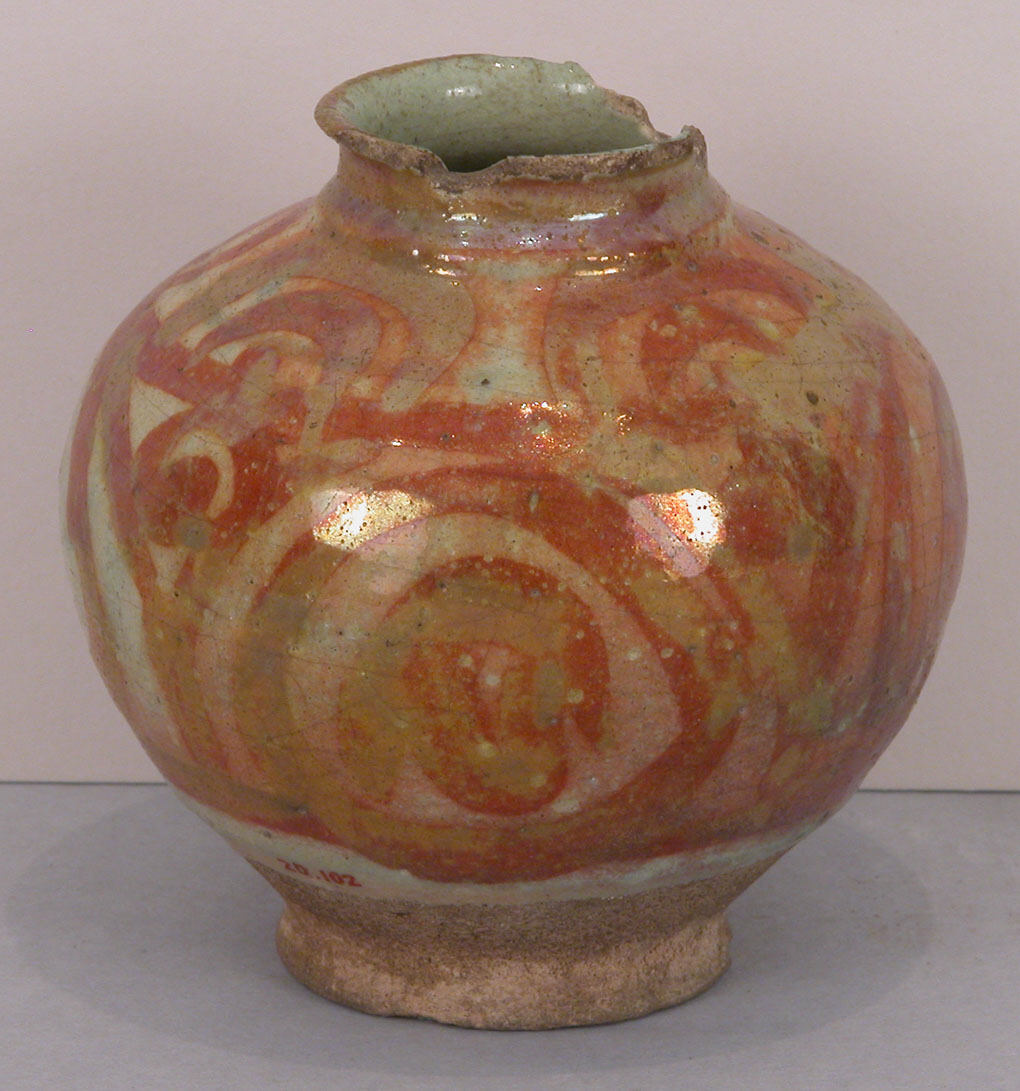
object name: vase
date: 1101-1200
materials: glaze, stonepaste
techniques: luster painting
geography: syria